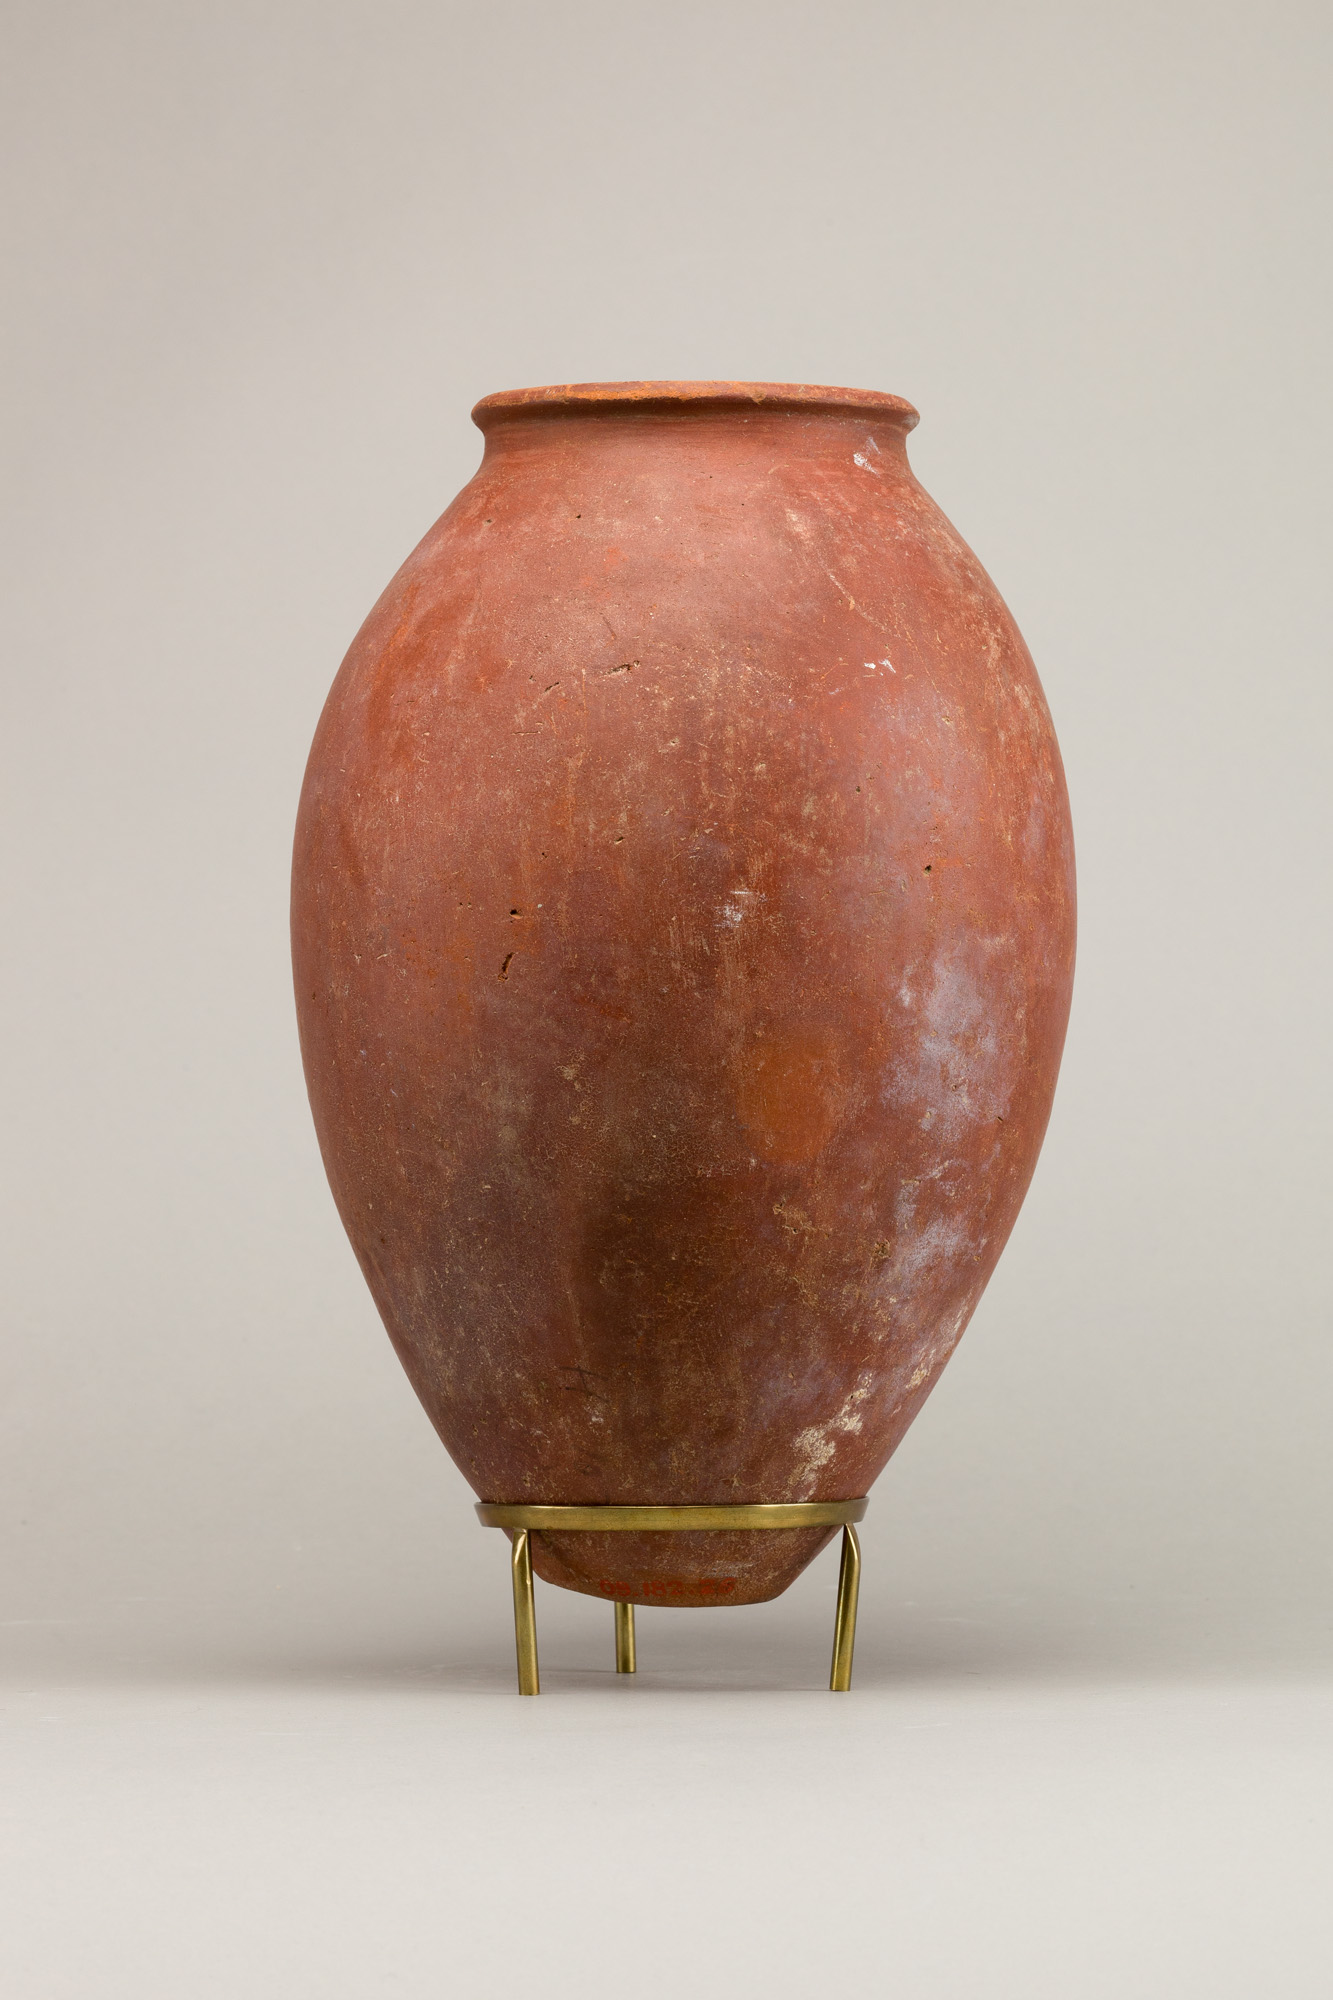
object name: jar, red polished ware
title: Red polished ware jar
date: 4500-4000 BCE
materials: pottery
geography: egypt